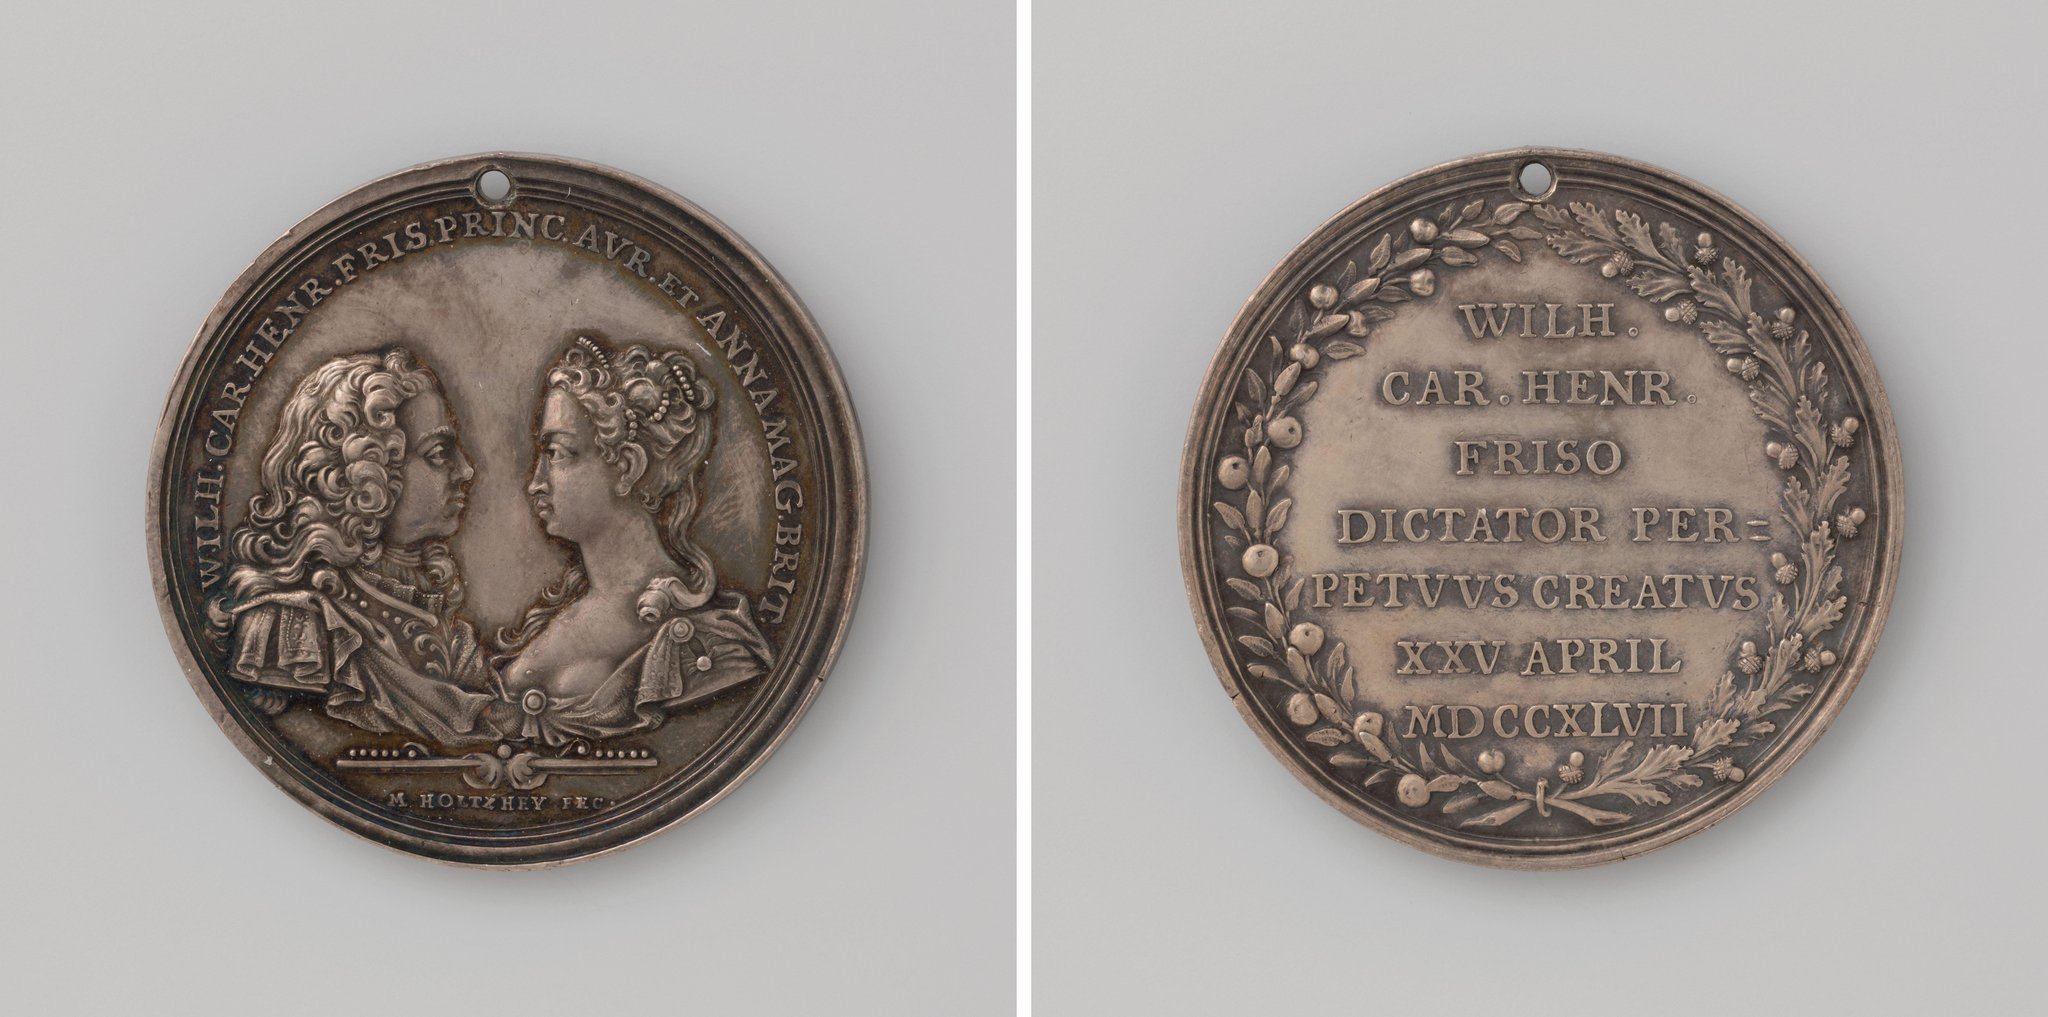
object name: history medal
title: Verheffing van de prins van Oranje tot stadhouder door de Staten van Zeeland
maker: martinus holtzhey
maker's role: medailleur, muntmaker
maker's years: 1697-1764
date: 1747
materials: silver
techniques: striking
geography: amsterdam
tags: the hague, willem iv (prins van oranje-nassau), zeeland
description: Zilveren penning met gat erin. Voorzijde: naar elkaar gewende borststukken van man en vrouw met diadeem binnen omschrift. Keerzijde: opschrift binnen samengevlochten oranjetak en eikentak